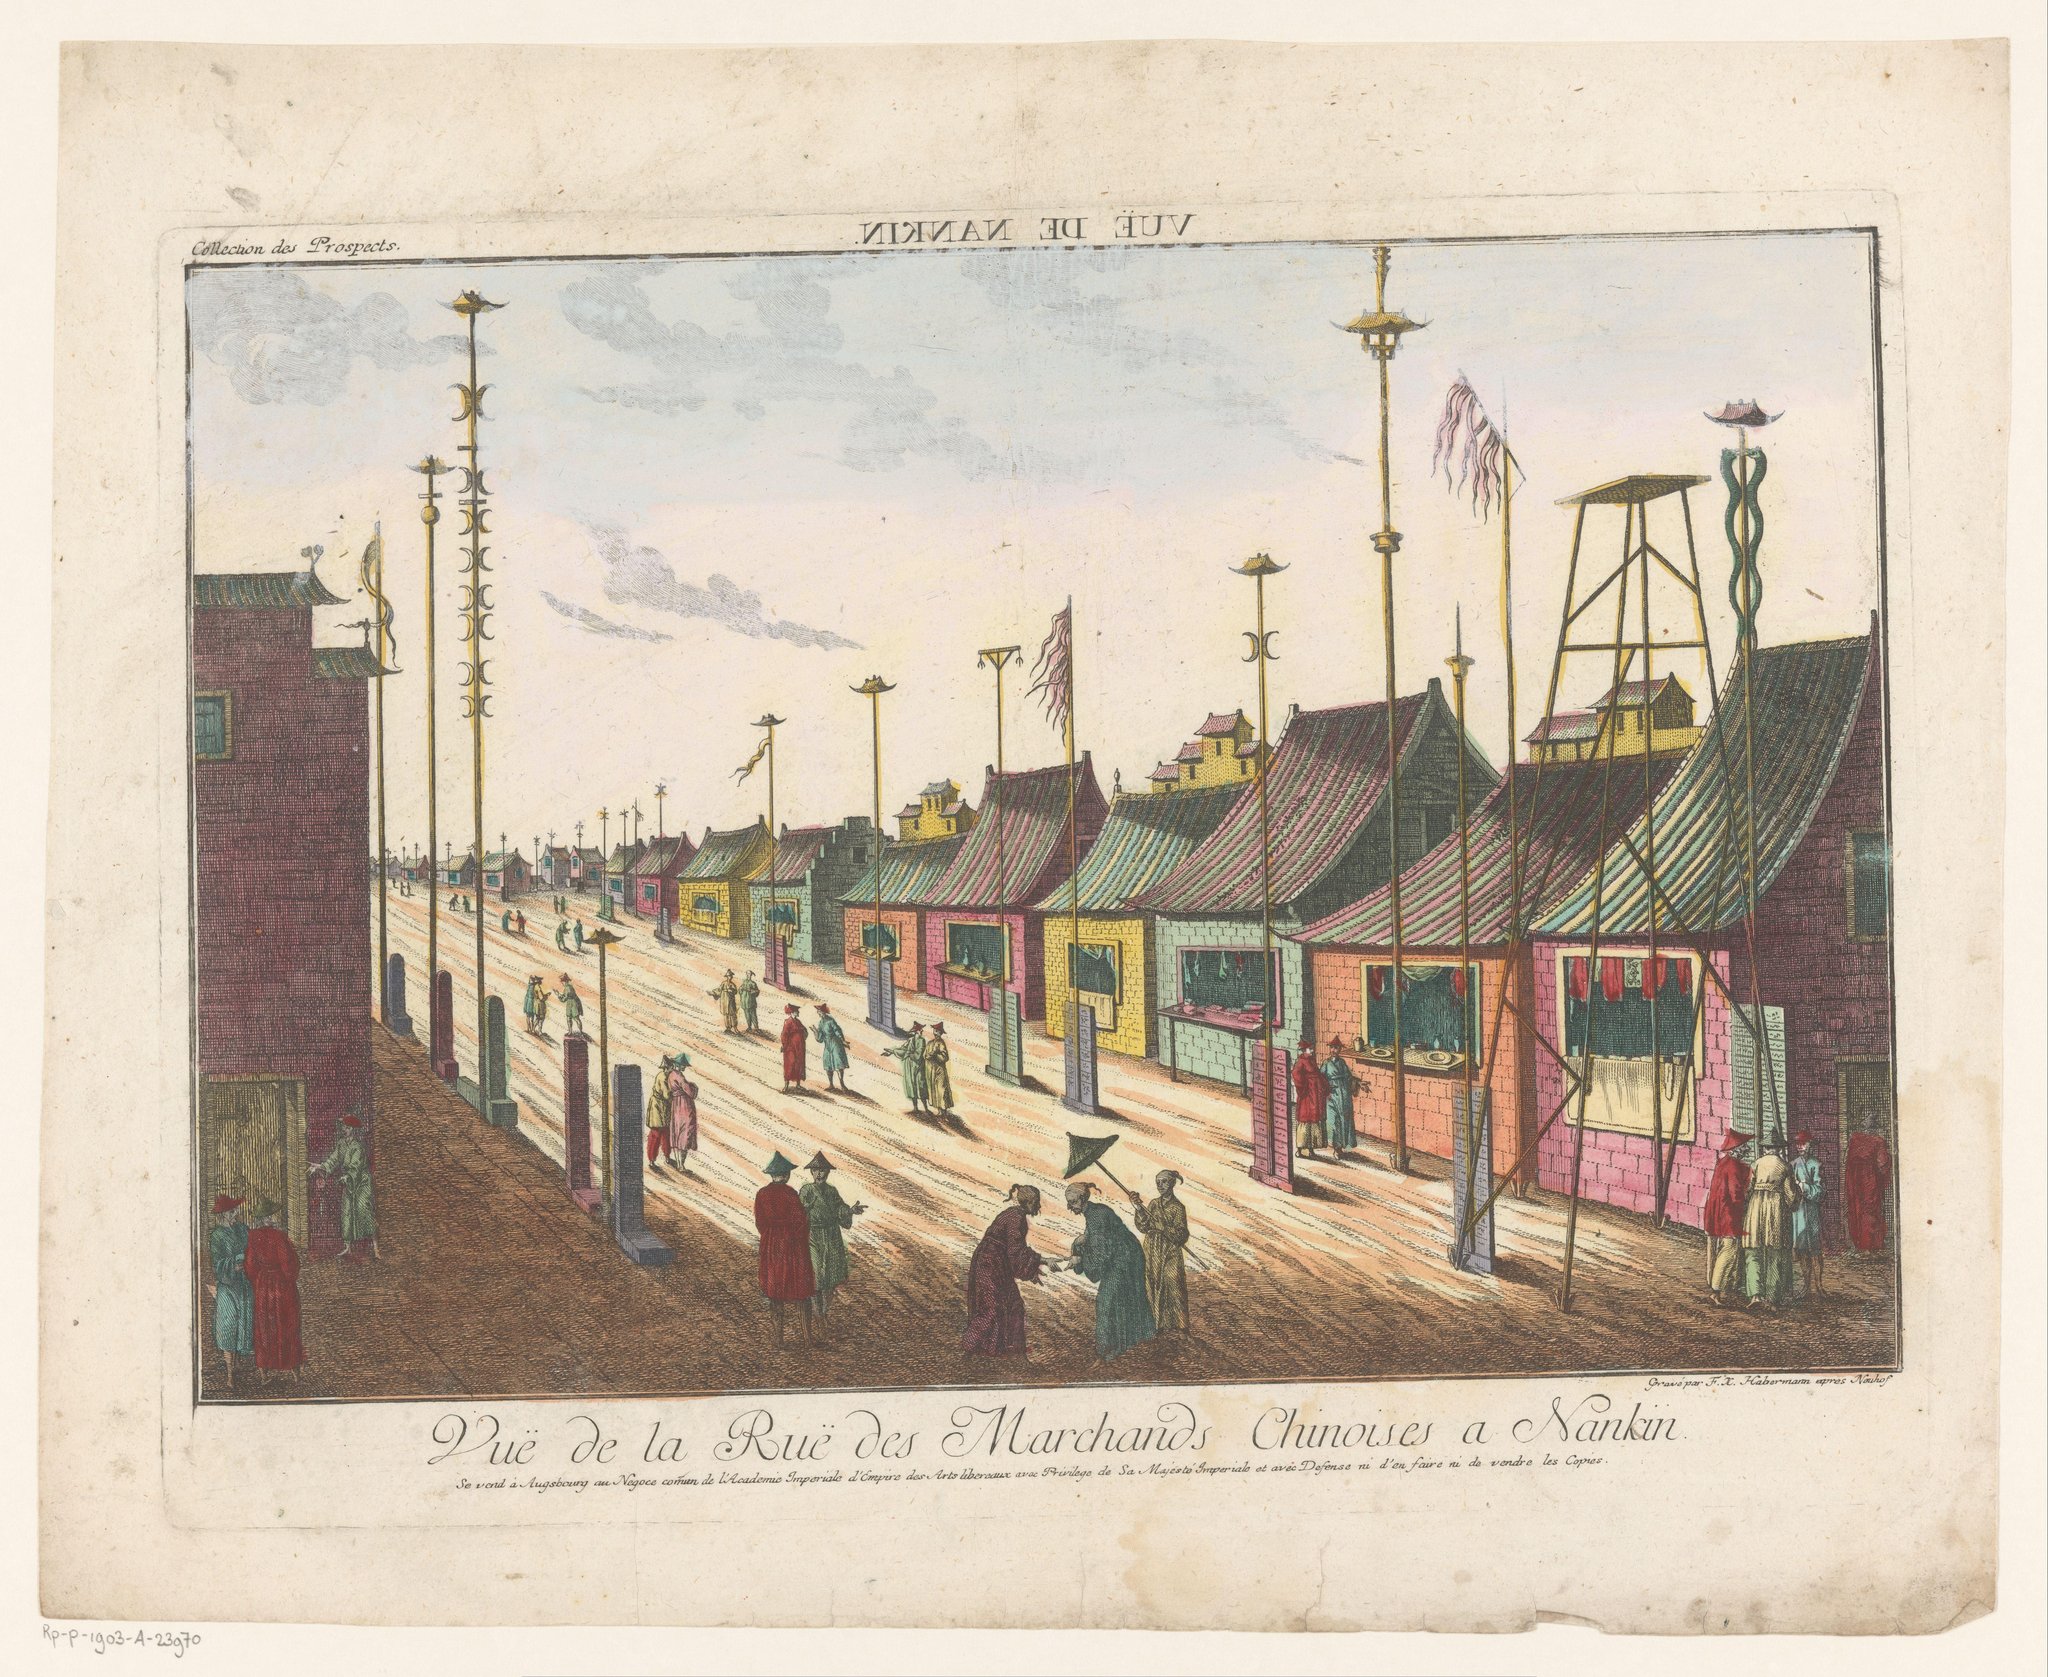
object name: opticaprent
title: Gezicht op een straat in Nanking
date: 1755-1779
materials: paper, watercolor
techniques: brush, etching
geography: augsburg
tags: city-view, and landscape with man-made constructions, chinese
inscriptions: collector's mark: Lugt 2228